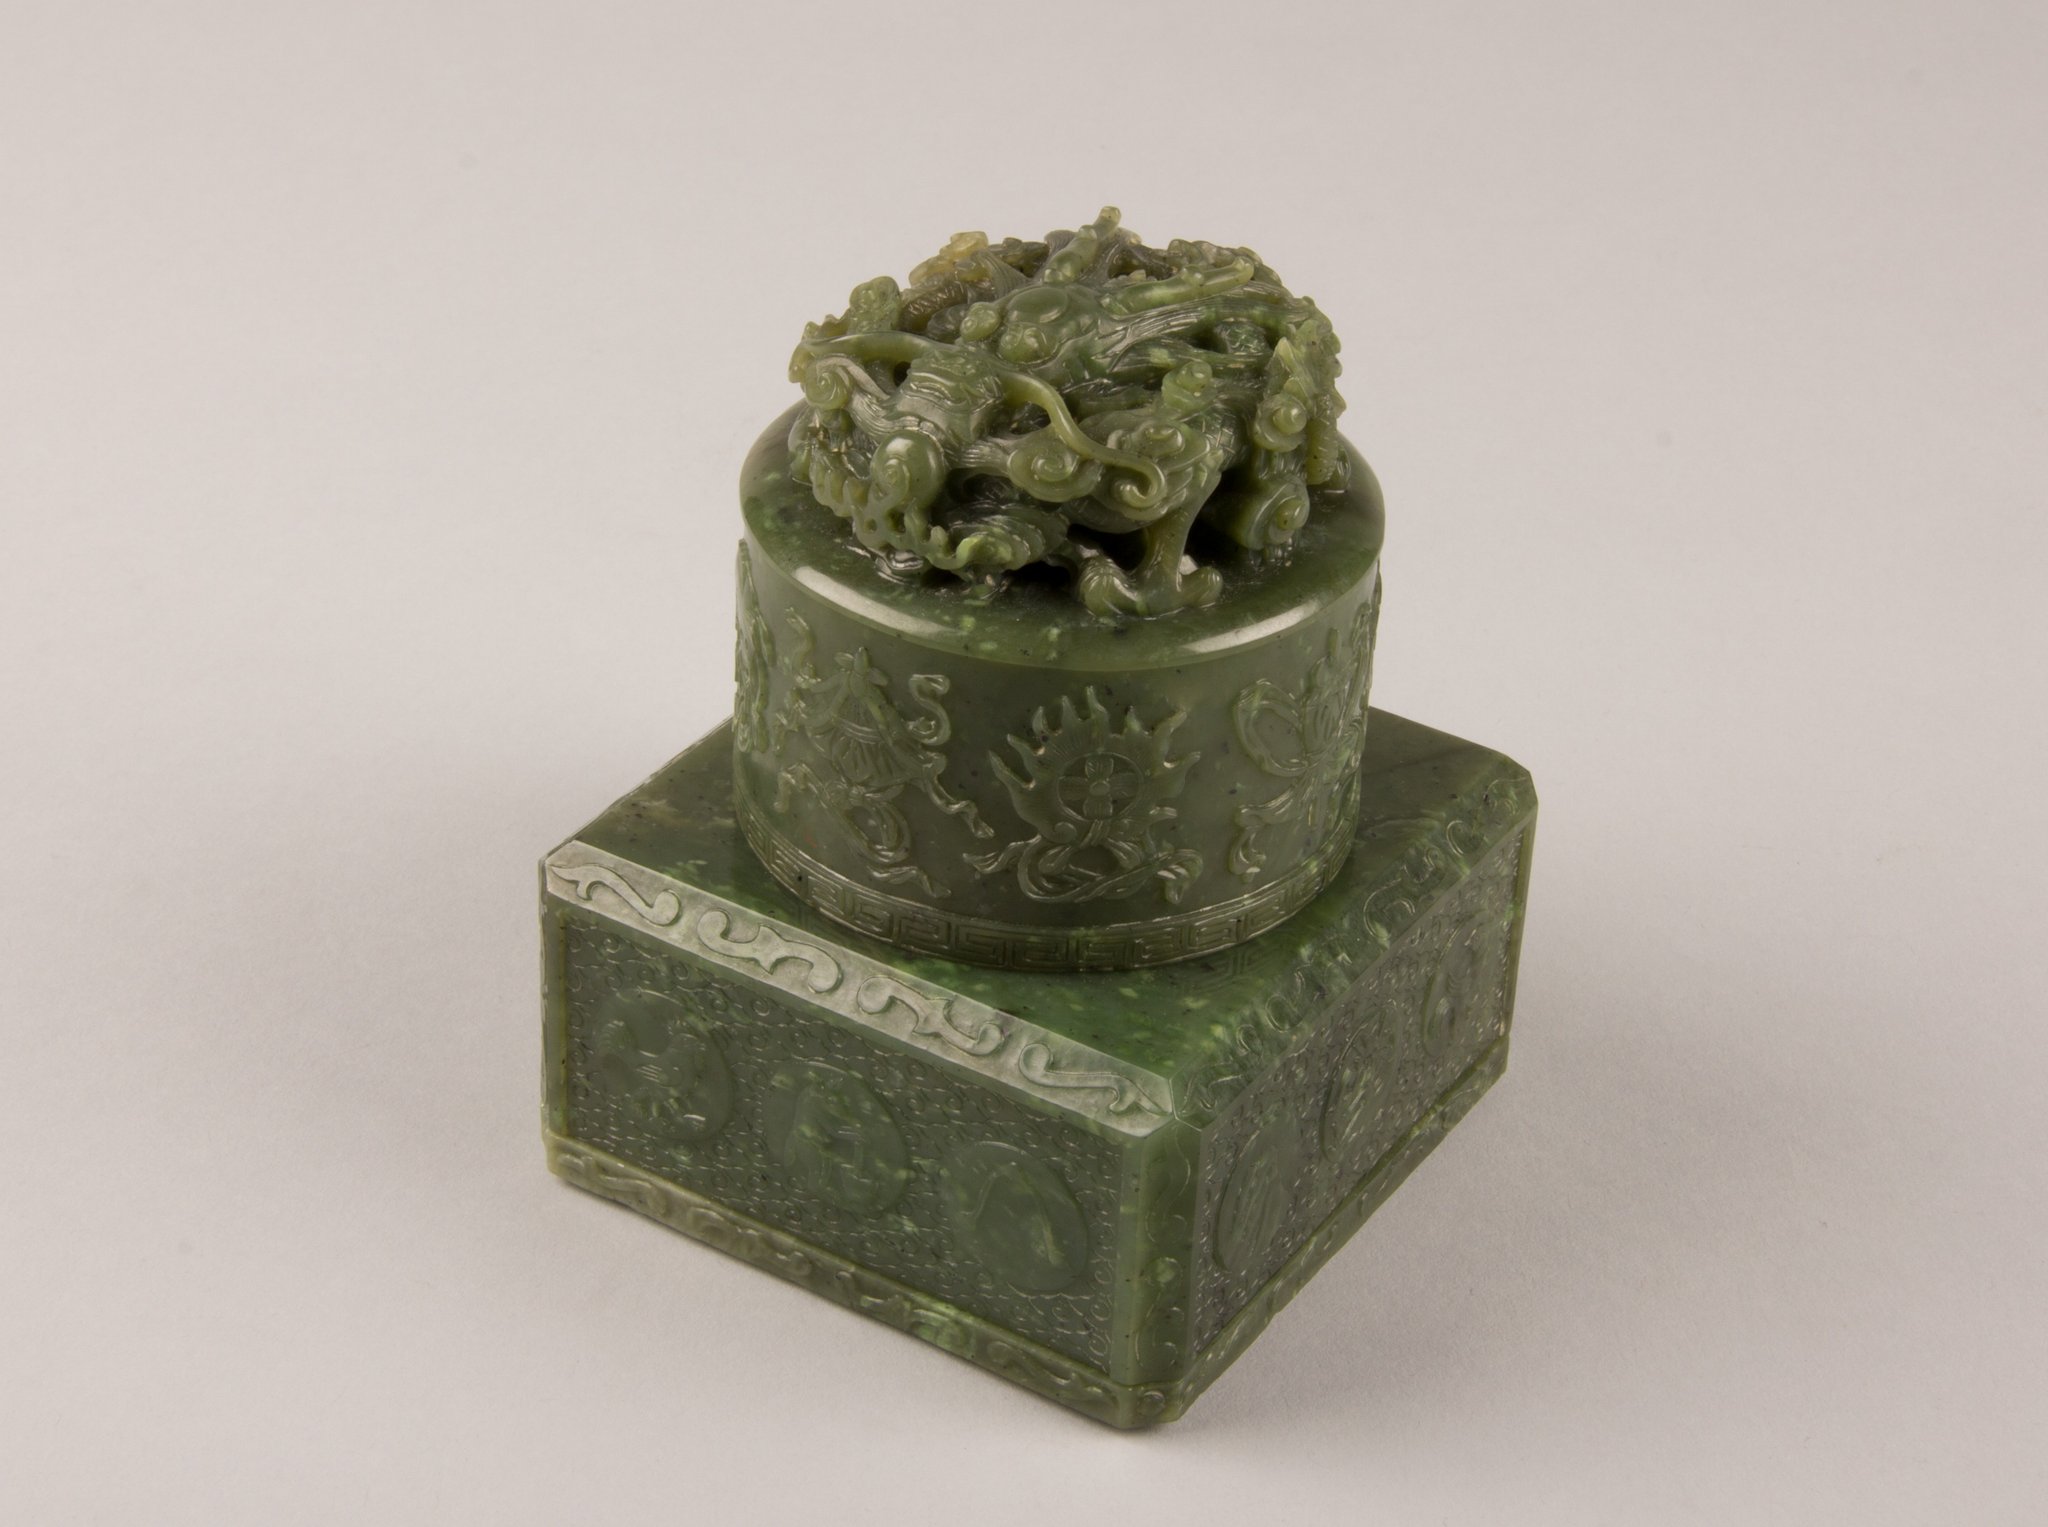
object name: seal casket with cover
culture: chinese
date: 1701-1900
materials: jade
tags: dragons